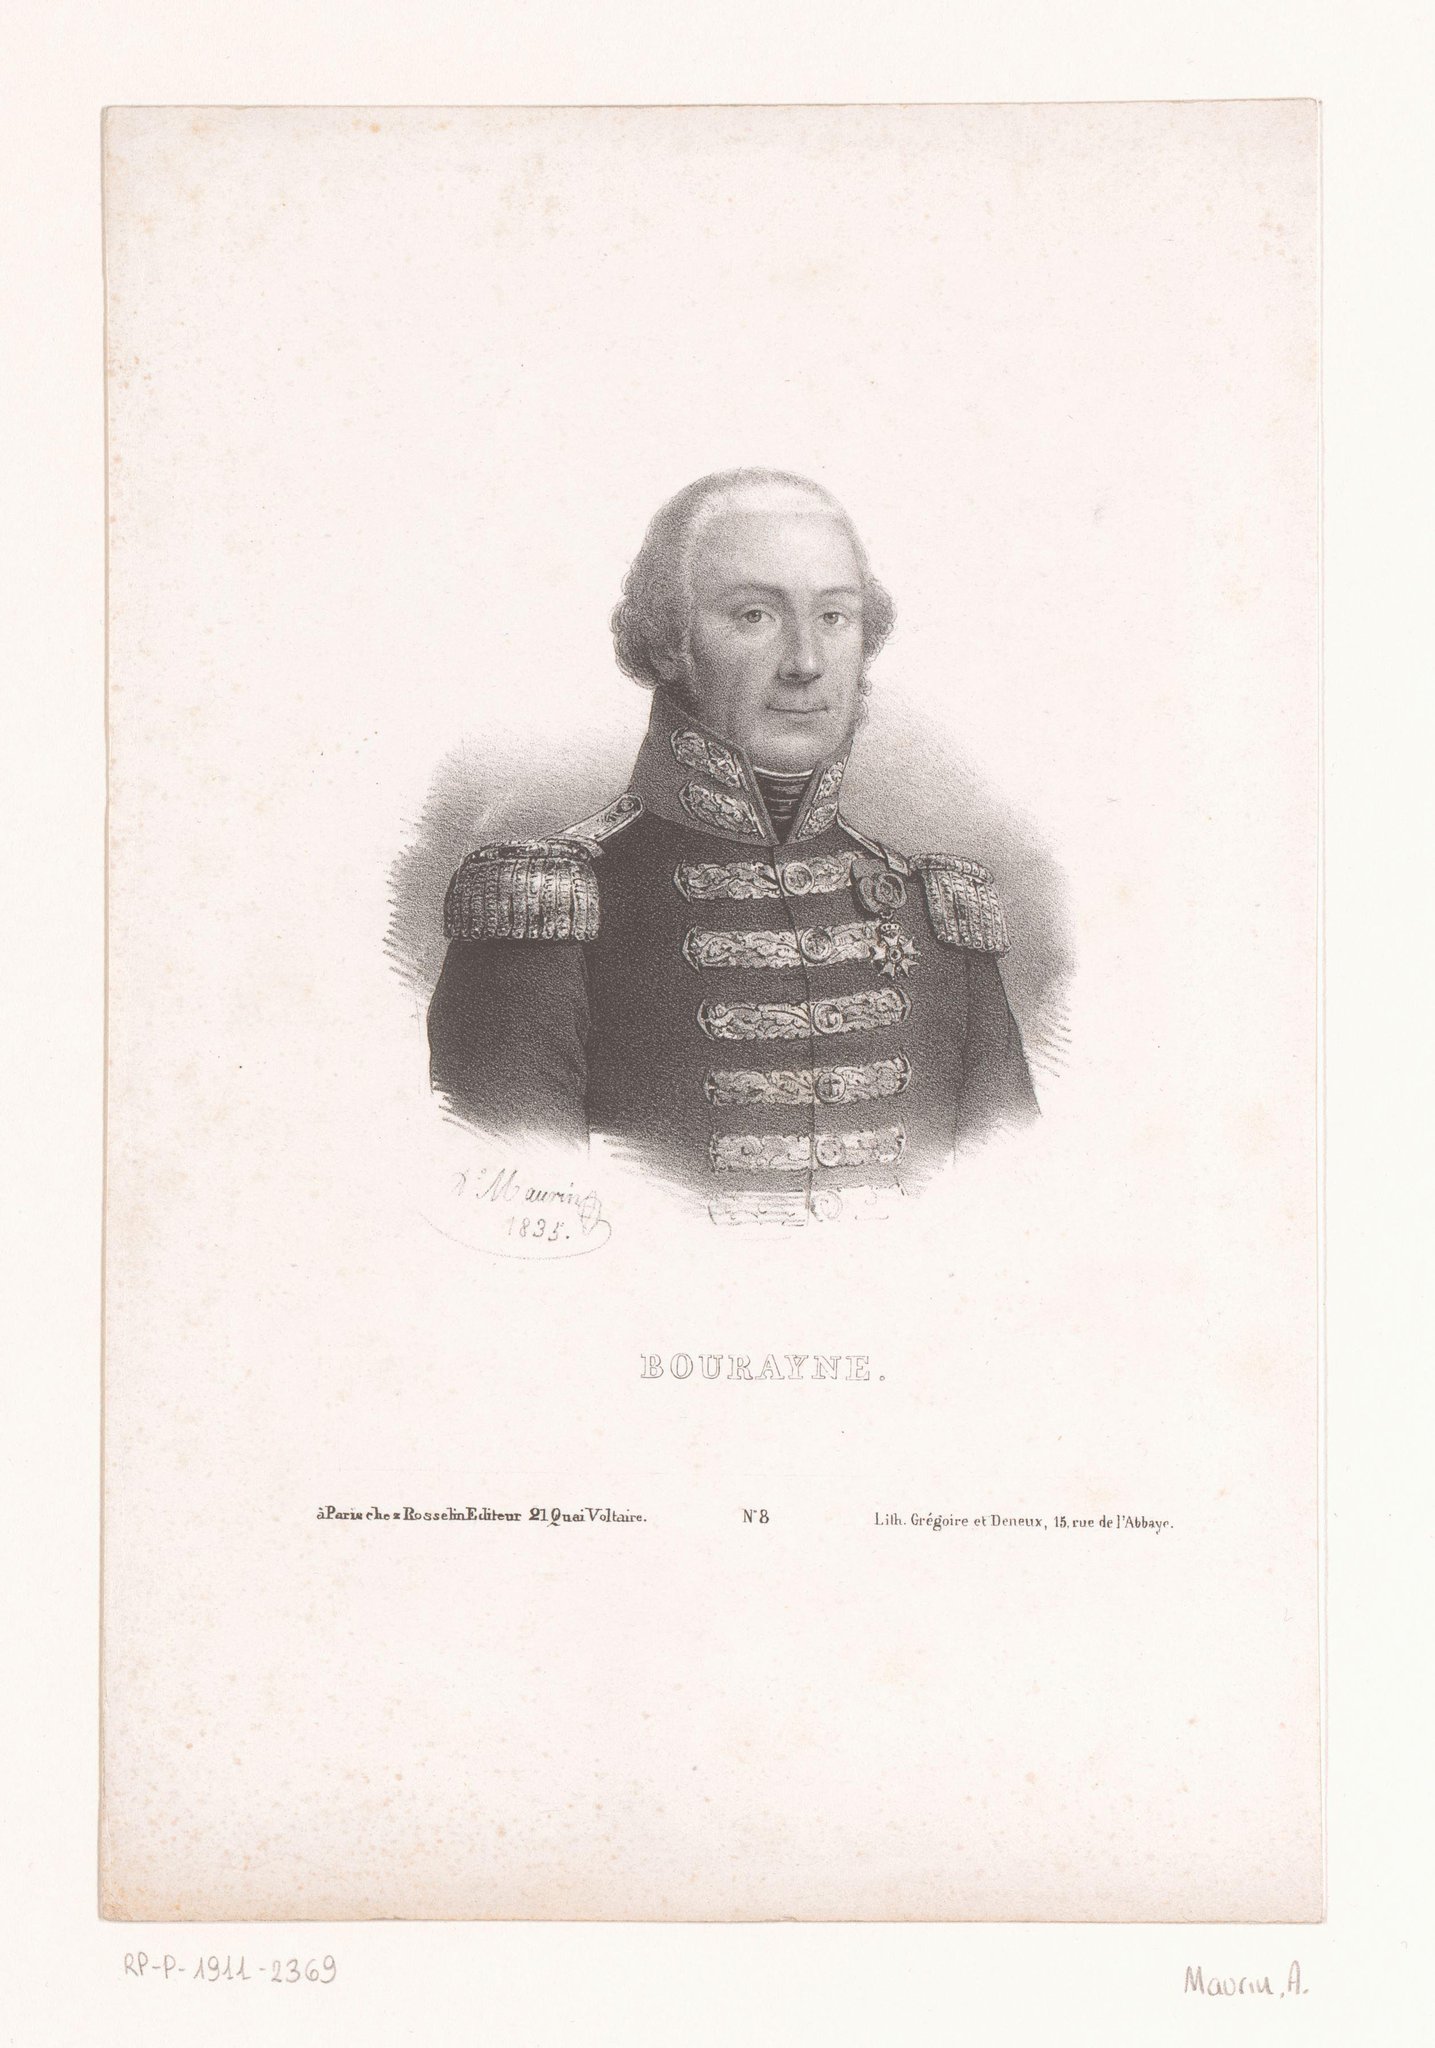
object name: print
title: Bourayne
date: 1835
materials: paper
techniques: lithograph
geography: paris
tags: naval officer, historical persons, officer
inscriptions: collector's mark: Lugt 2228